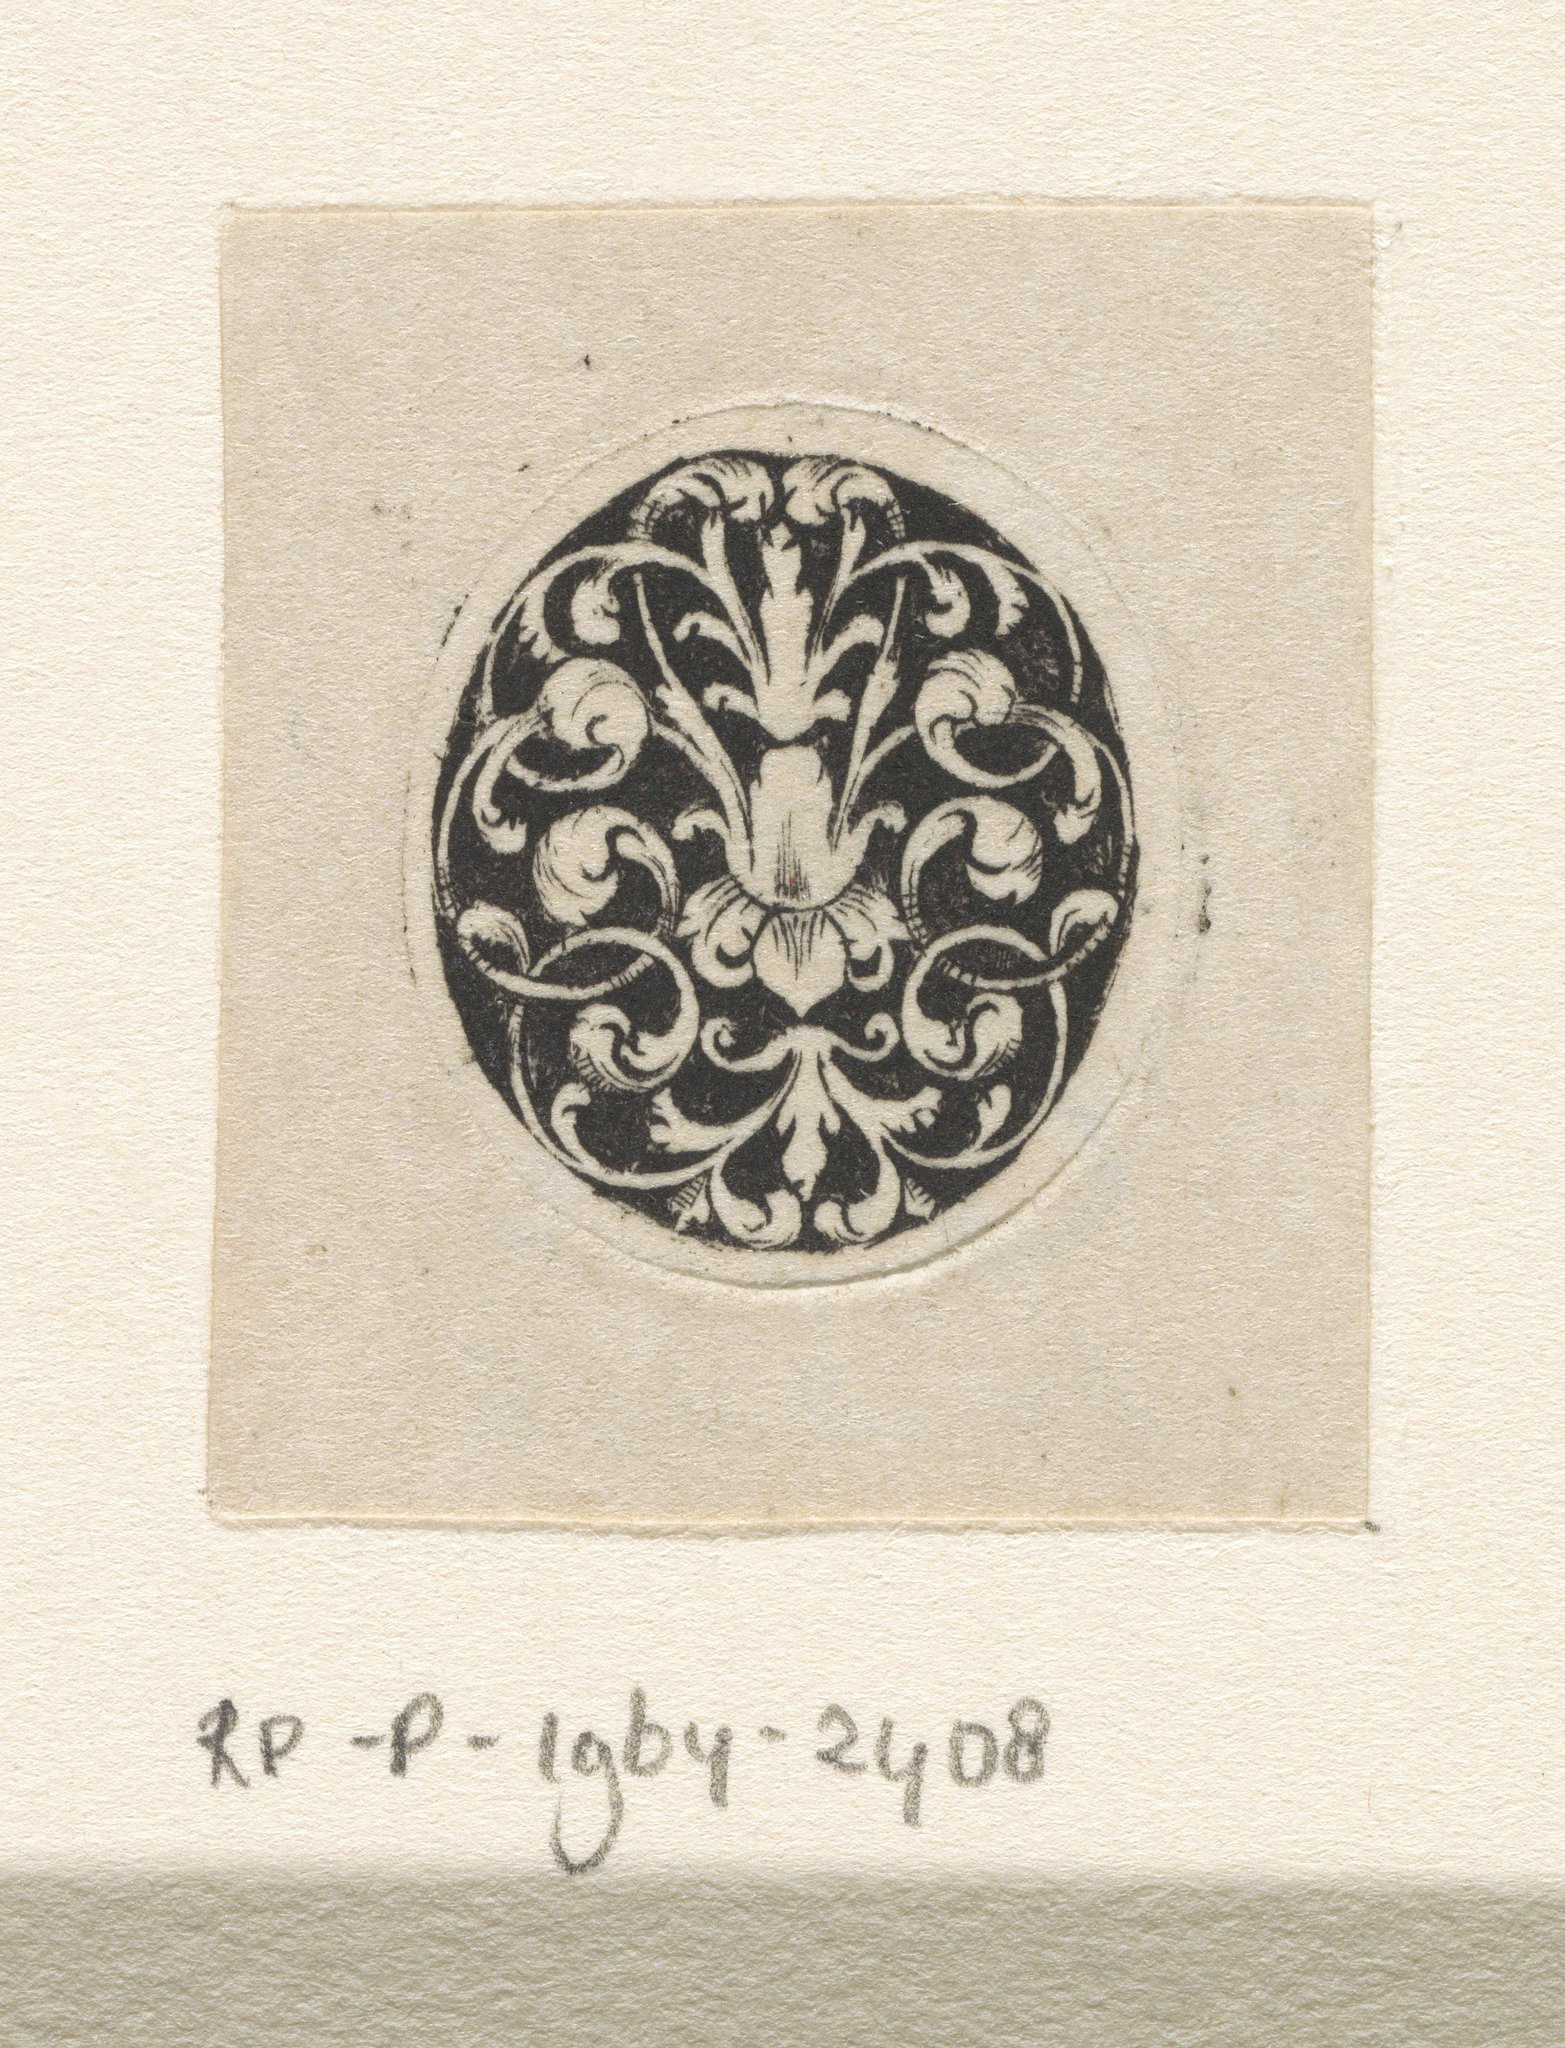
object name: ornament print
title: Bladranken in ovaal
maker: isaac walraven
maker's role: draughtsman, painter, print maker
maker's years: 1686-1765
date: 1696-1765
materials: paper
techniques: engraving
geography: amsterdam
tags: foliage, tendrils, branches ~ ornament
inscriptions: collector's mark: Lugt 2760, collector's mark: Lugt 2228